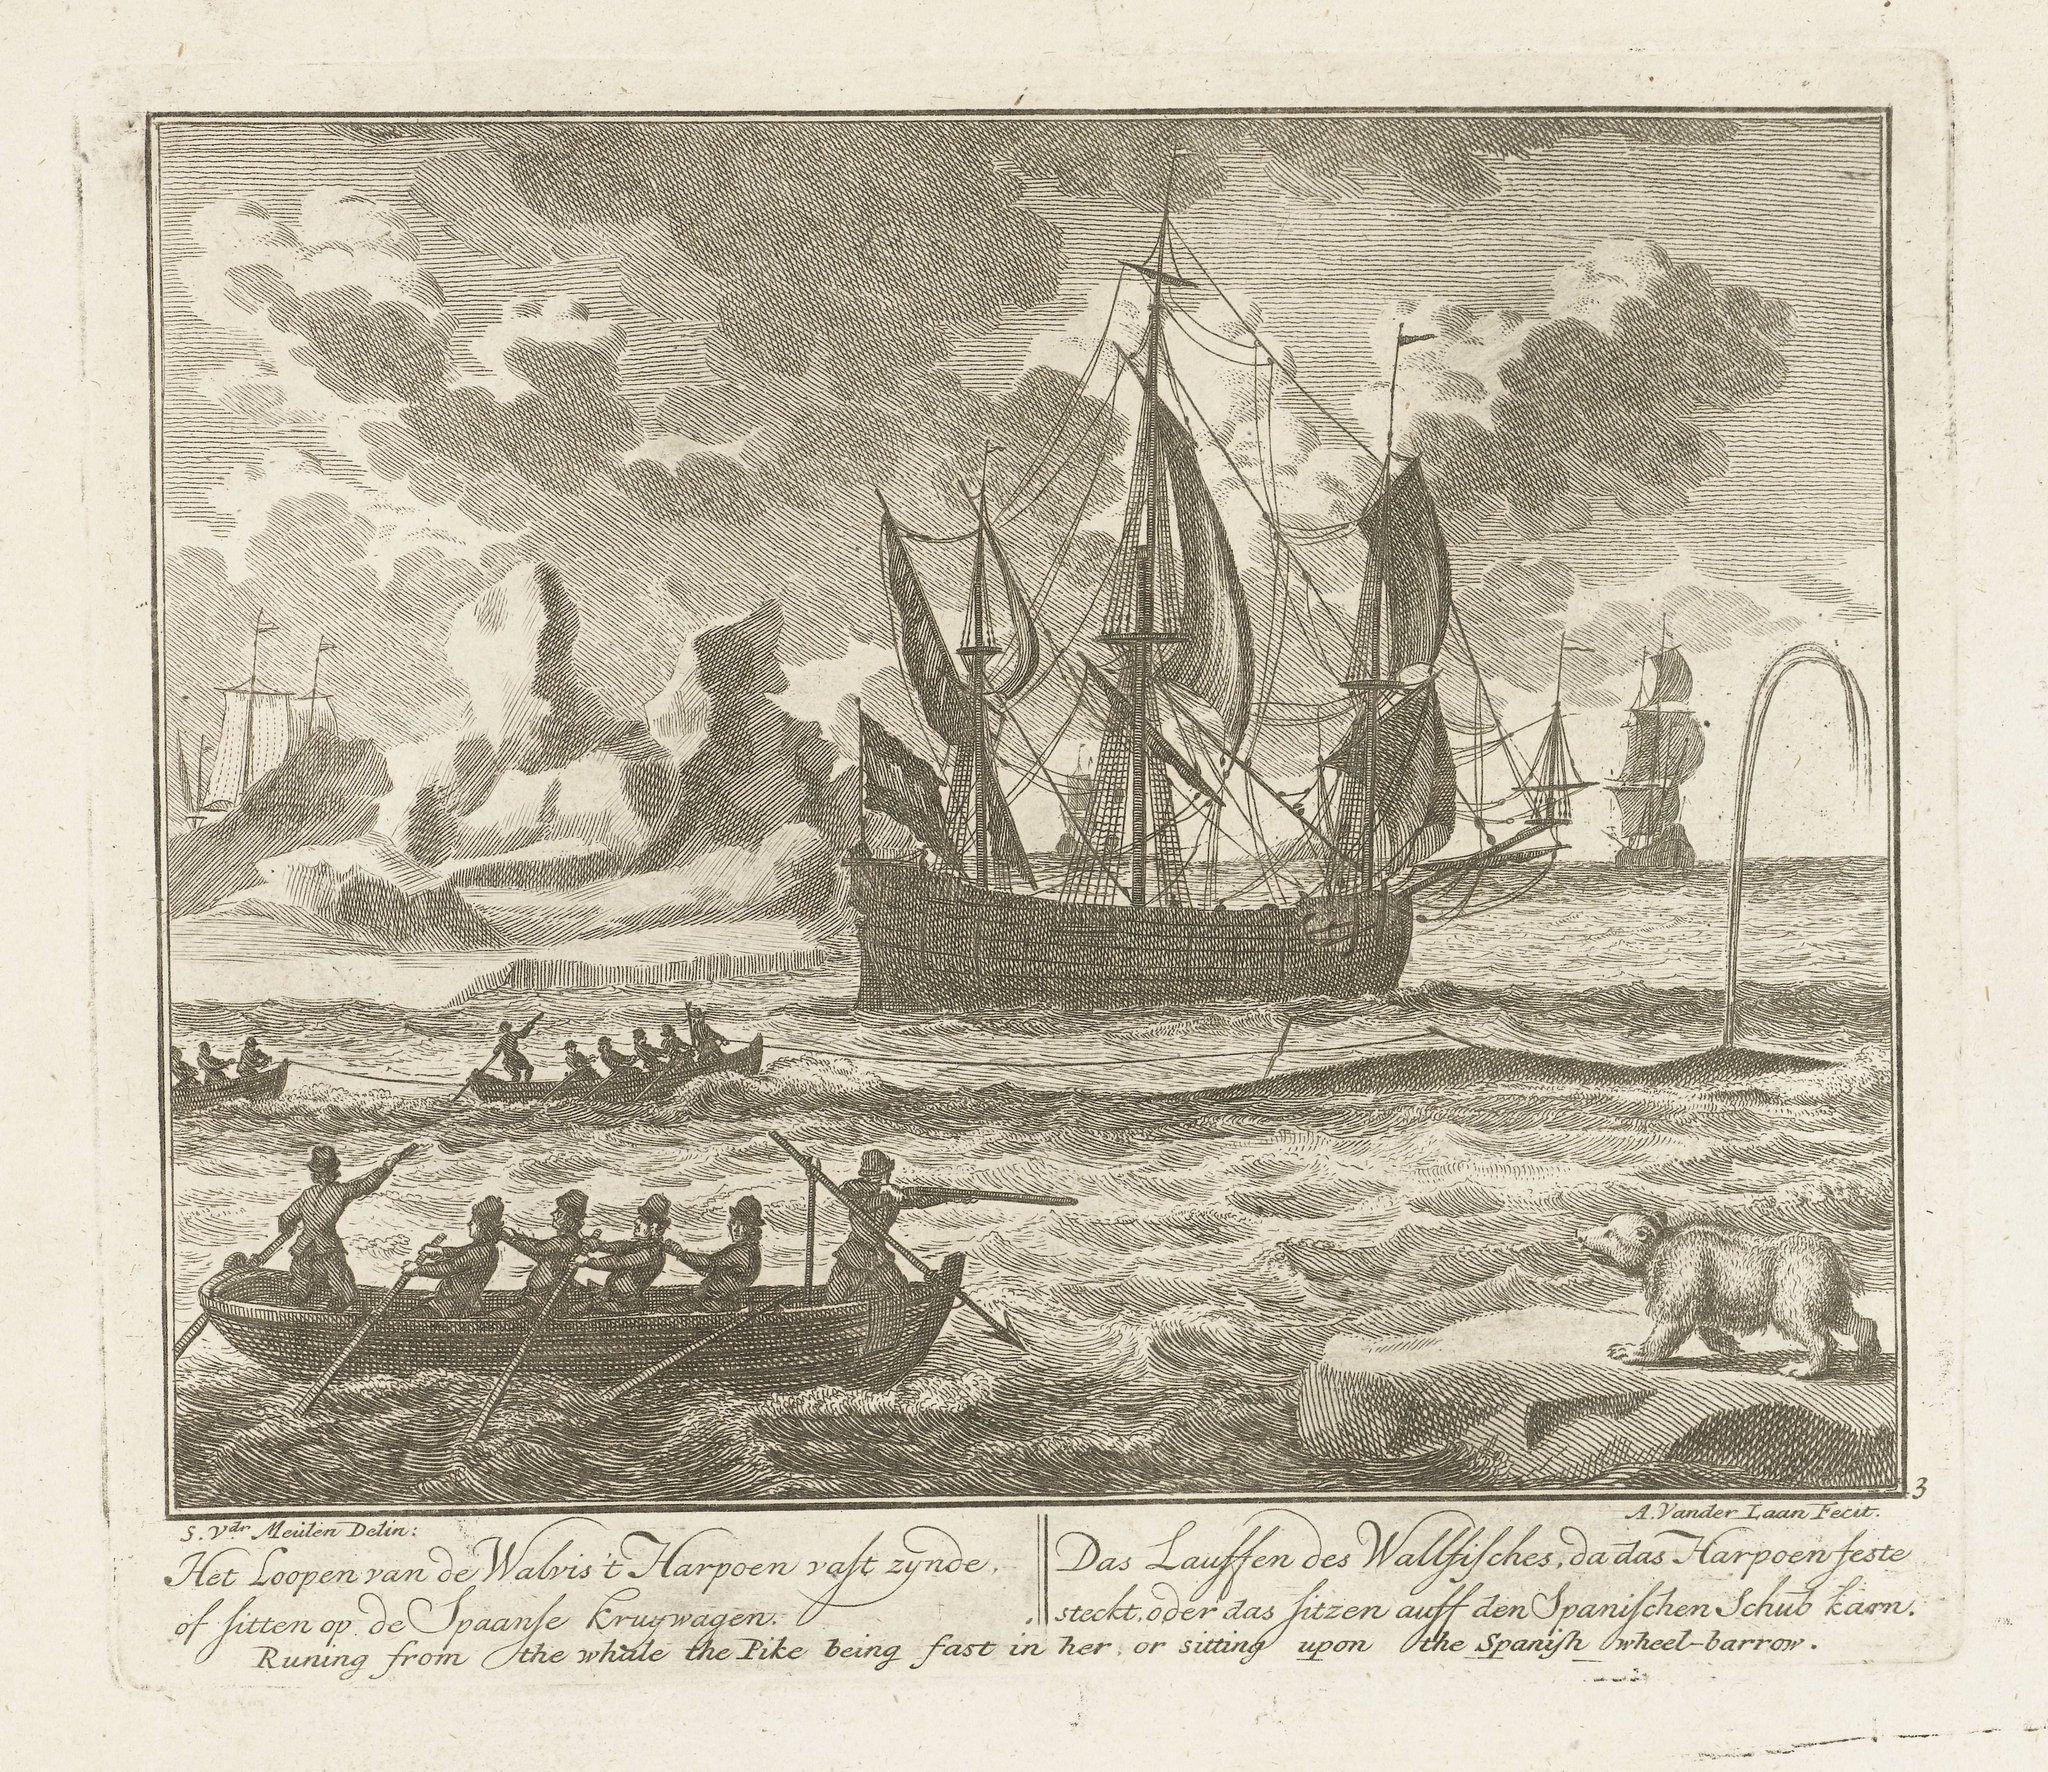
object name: print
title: Lopen van de geharpoeneerde walvis, ca. 1725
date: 1720-1730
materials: paper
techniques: etching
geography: amsterdam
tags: whale fishery, whaling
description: Het lopen van de geharpoeneerde walvis, de lijn vastgehouden vanuit sloepen; ook bekend als het zitten op de Spaanse kruiwagen, ca. 1725. Op de voorgrond schiet een matroos op een ijsbeer. Onderdeel van de serie over de walvisvangst. Gedrukt op hetzelfde blad als nr. 4.